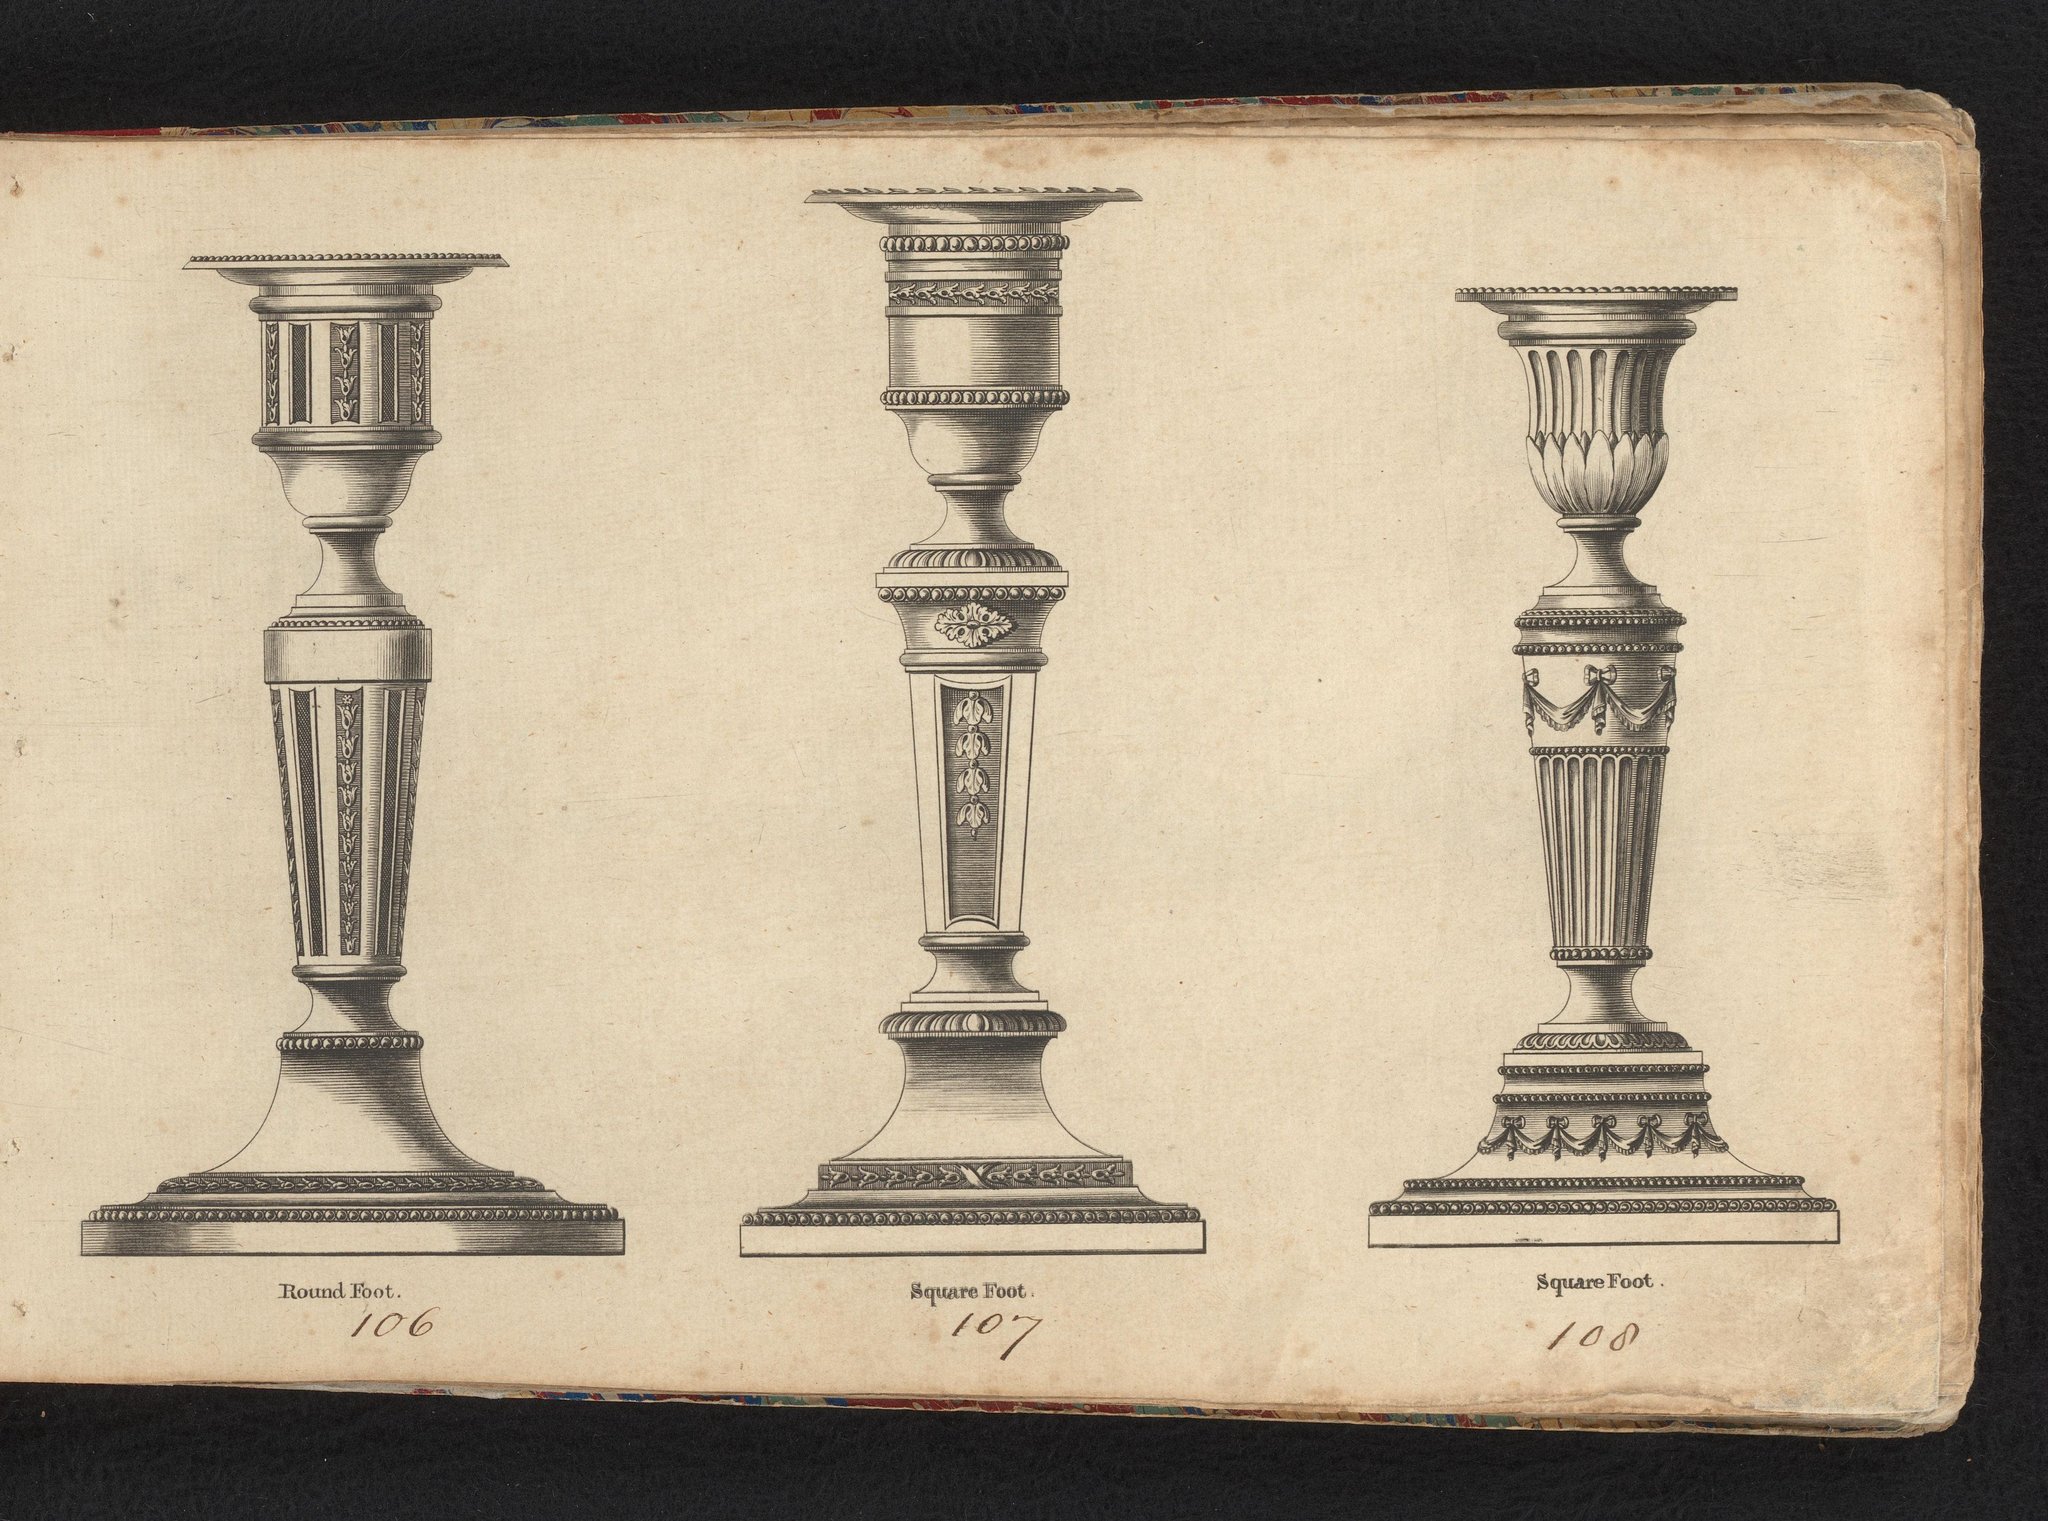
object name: ornament print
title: Drie ontwerpen voor kandelaren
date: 1784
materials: paper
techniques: engraving, etching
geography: england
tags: candlestick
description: Twee ontwerpen voor kandelaren met ronde en vierkante voeten, op het volle blad. Met gedrukte onderschriften en handgeschreven nrs 106-108. Onderdeel van een catalogus met assortiment modellen van Sheffield verzilverd vaatwerk (pleet) door Matthew Boulton.